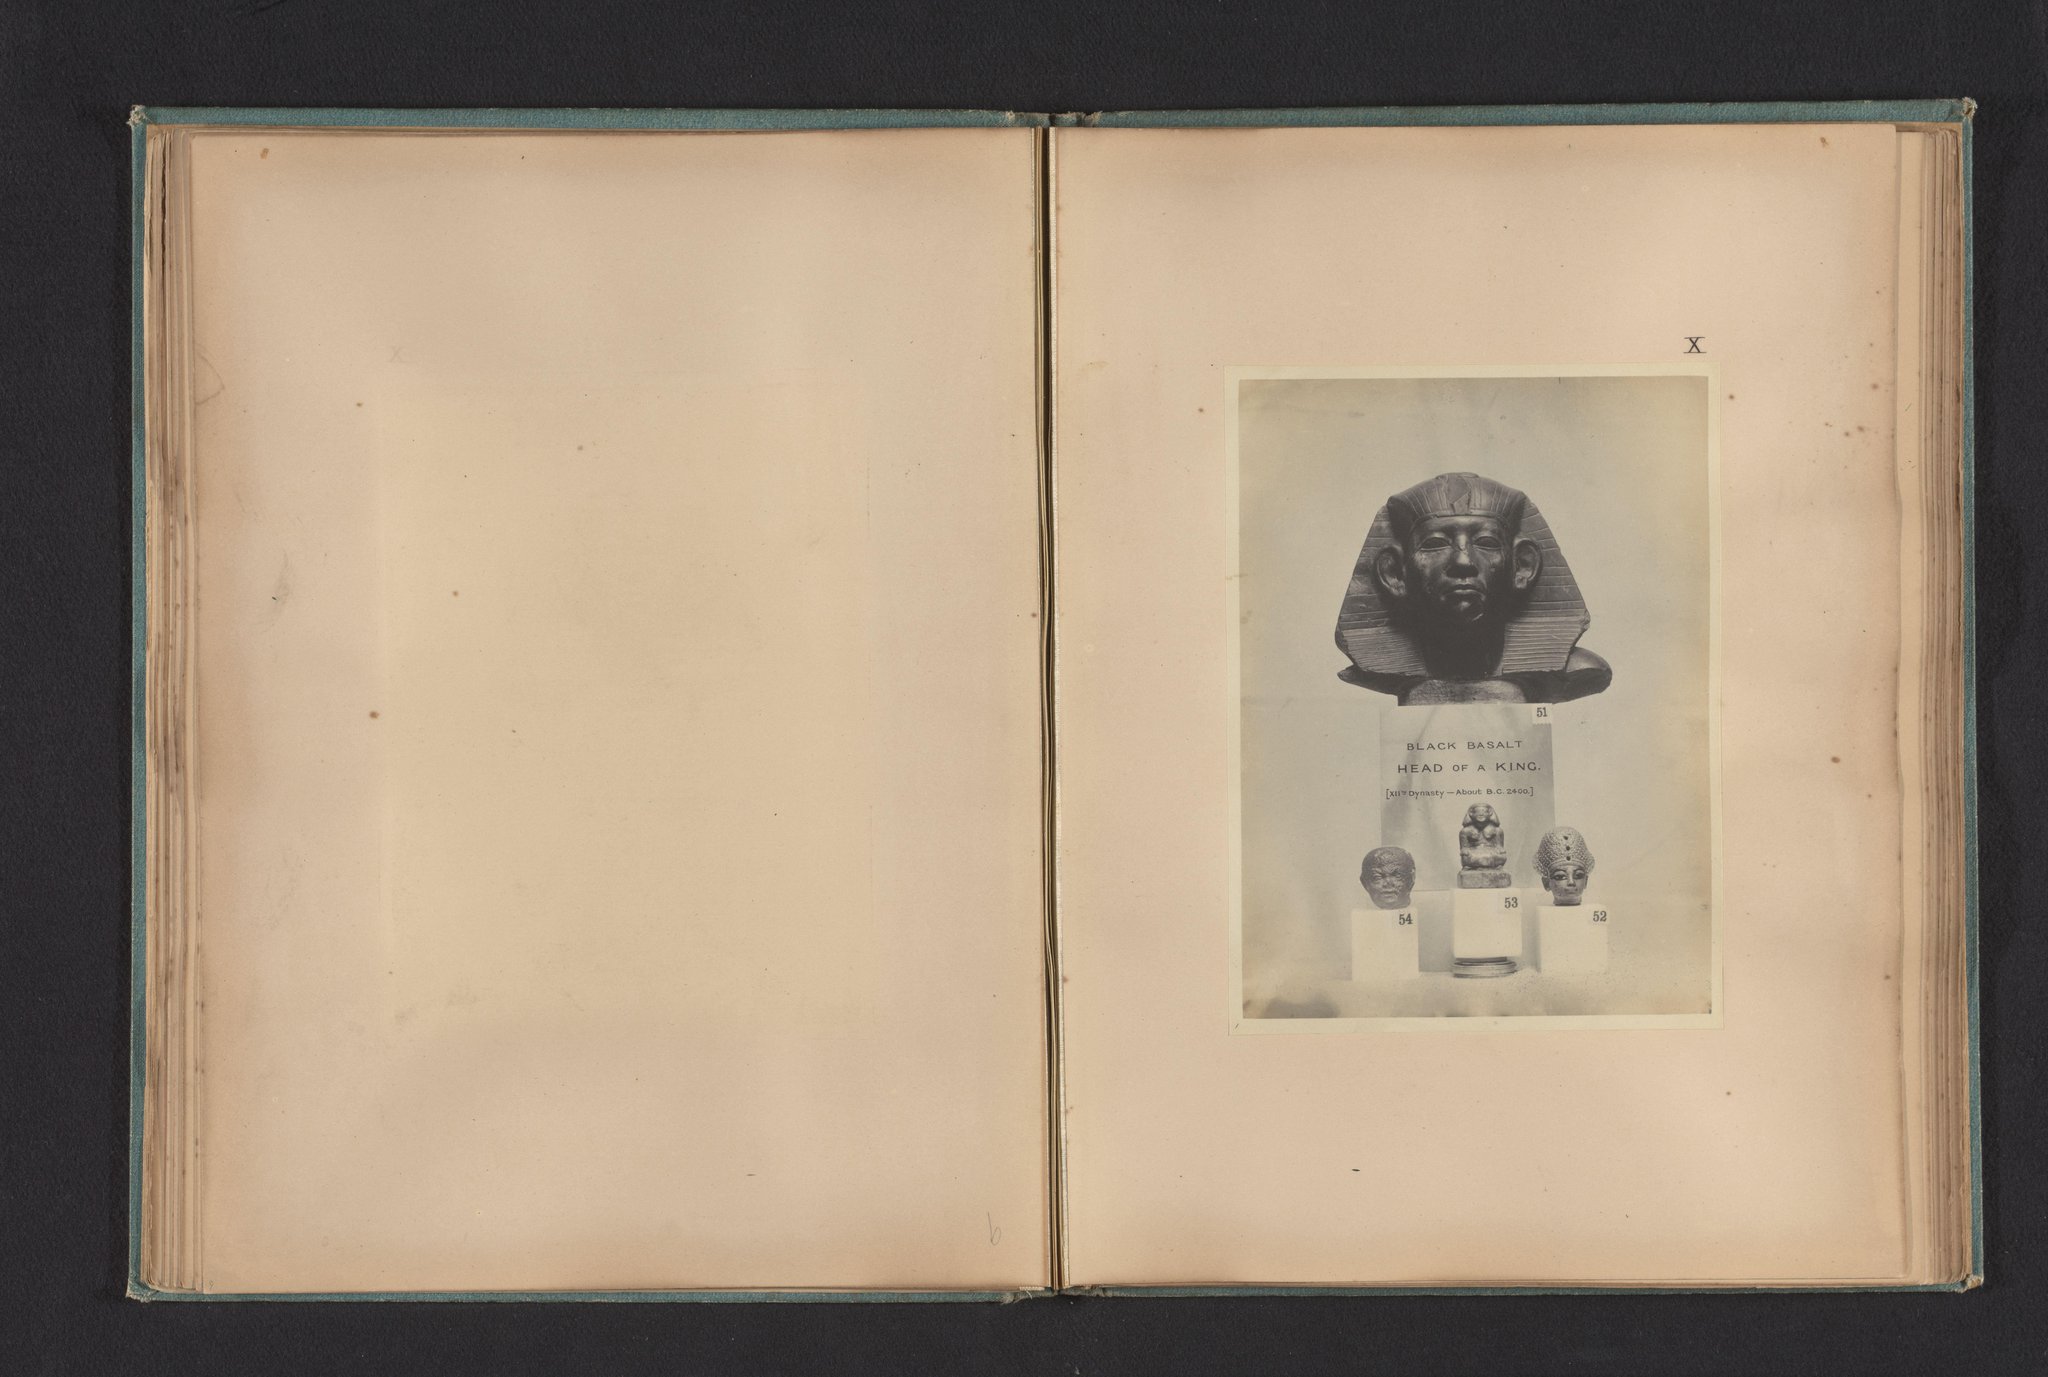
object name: page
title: Vier Egyptische objecten, waaronder een fragment van een sculptuur, het hoofd van een farao en een sculptuur van een zittende schrijver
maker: Anonymous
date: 1890-1895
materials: photographic support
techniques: gelatin silver print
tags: writer, poet, author, sculpture, king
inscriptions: number: ‘XII’